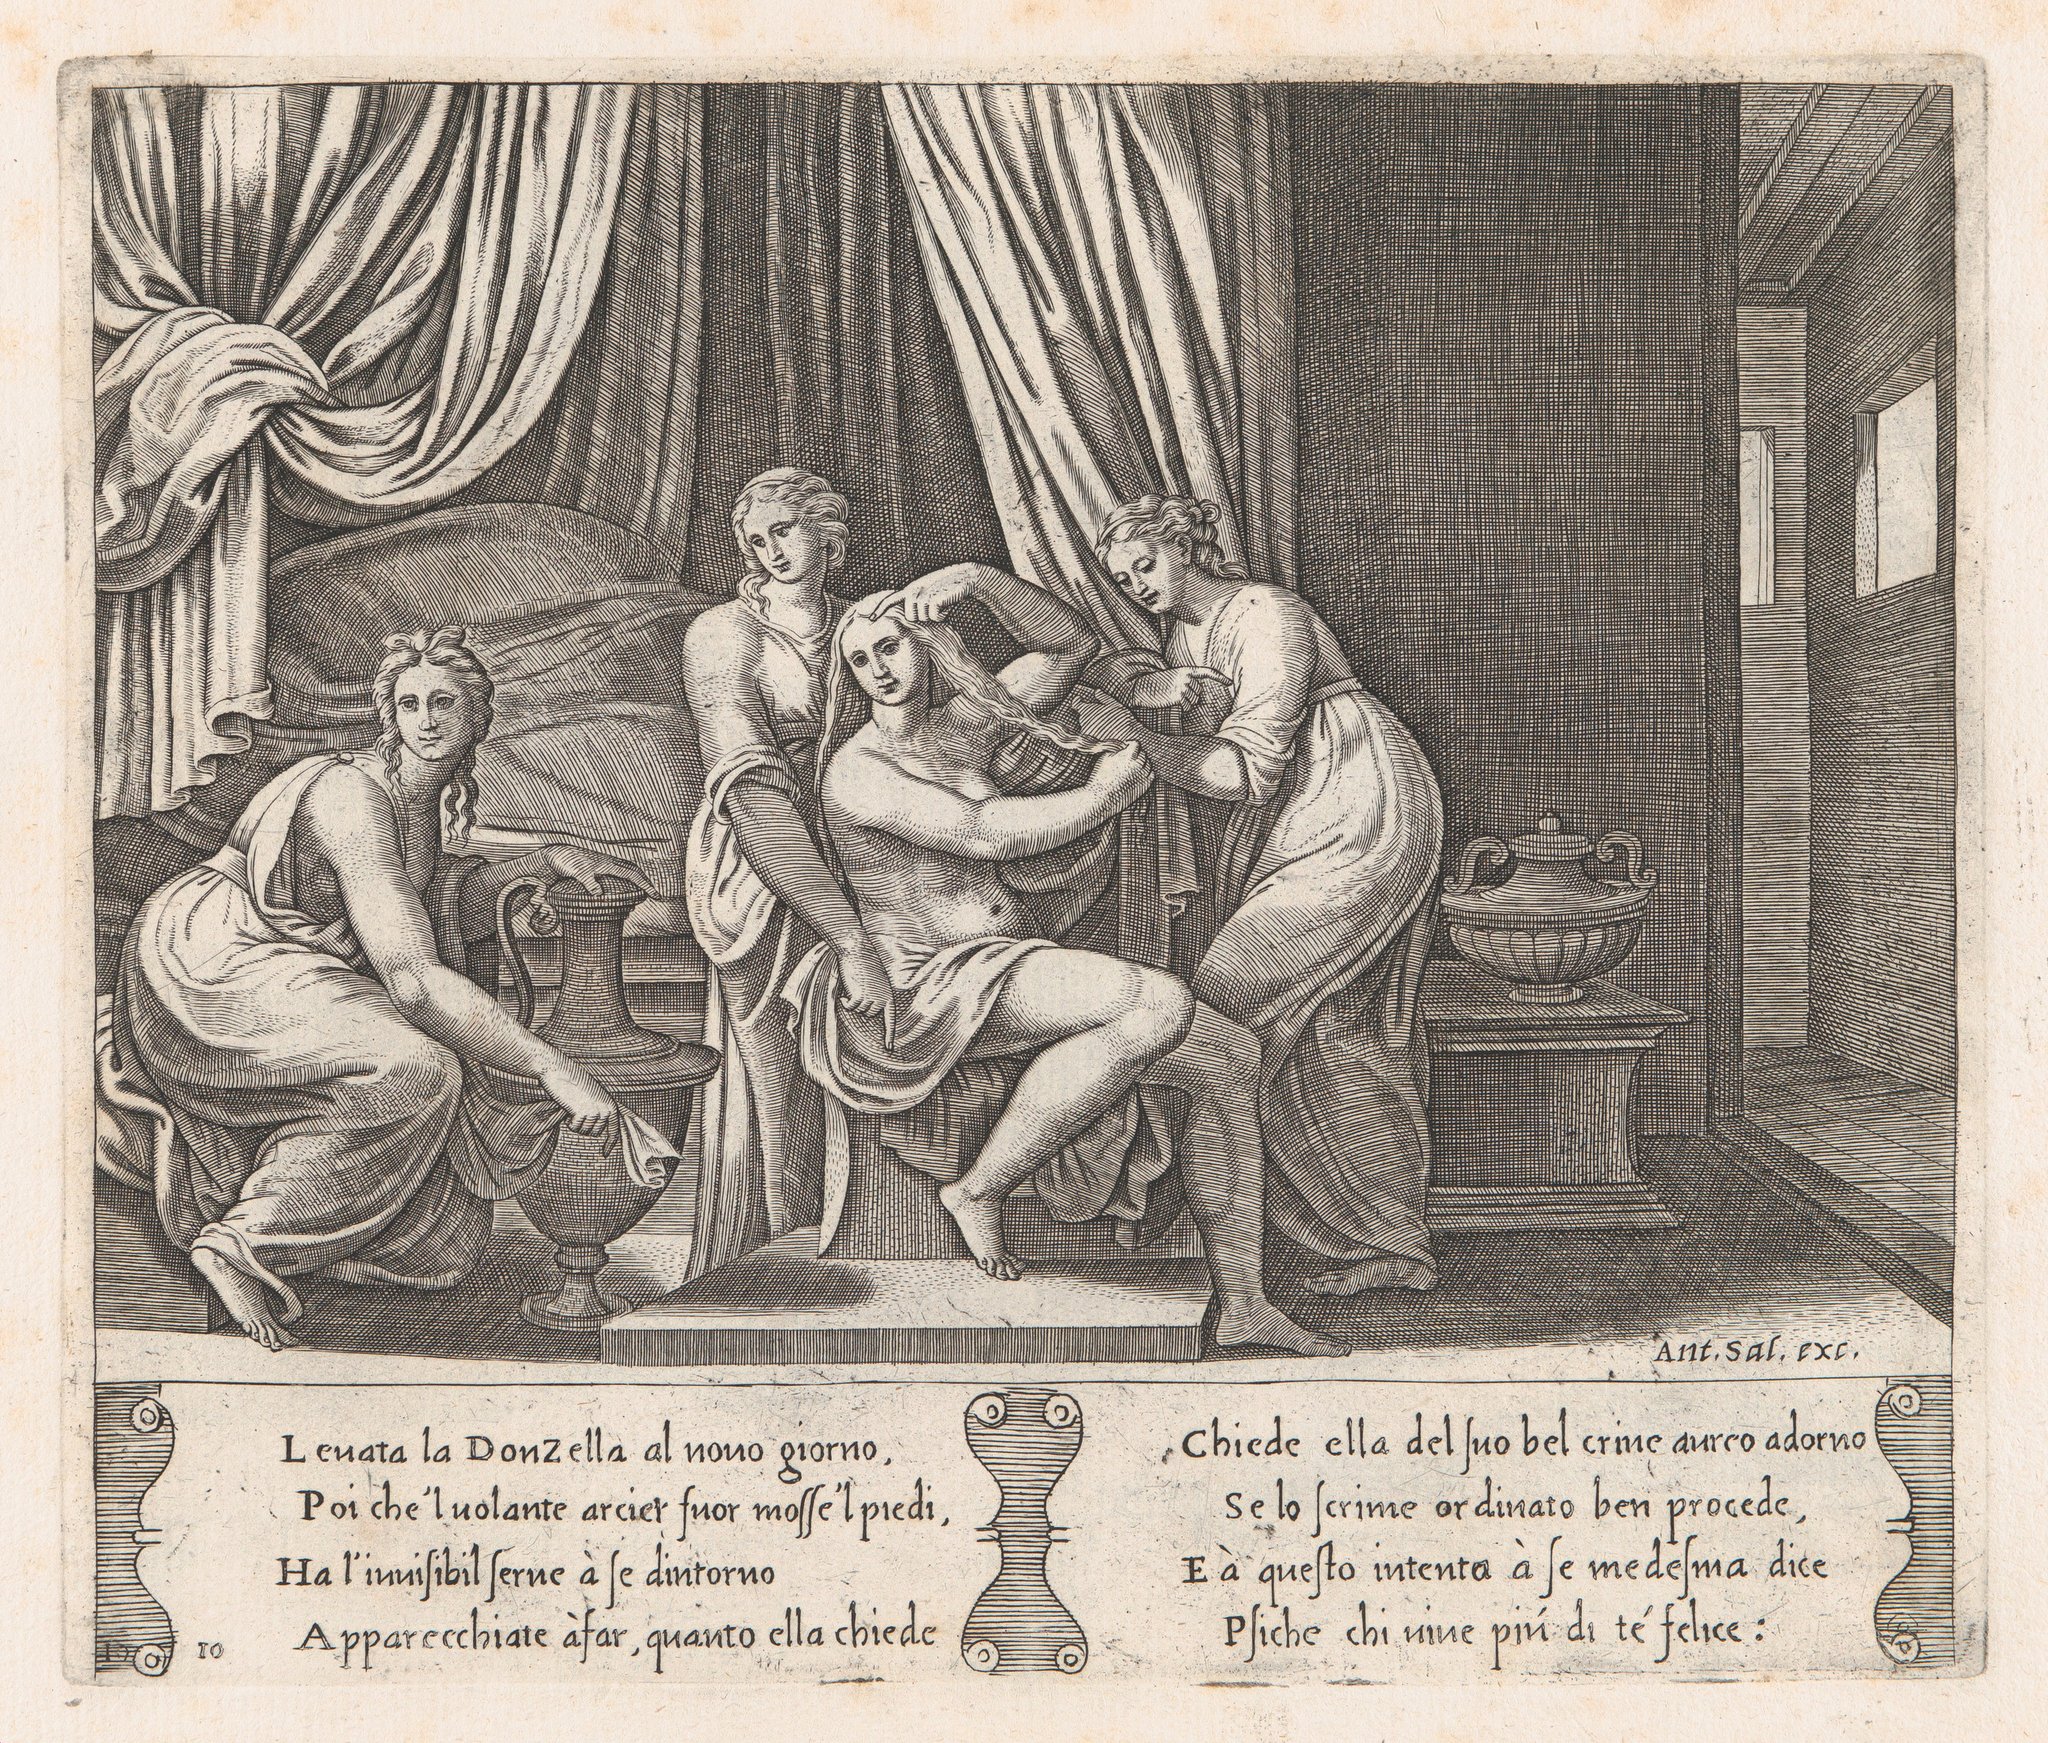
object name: print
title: Plate 10: Nymphs dressing Psyche's hair, from "The Story of Cupid and Psyche as told by Apuleius"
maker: master of the die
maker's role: artist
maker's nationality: italian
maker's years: 1525-1560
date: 1530-1560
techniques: engraving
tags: women,nymphs